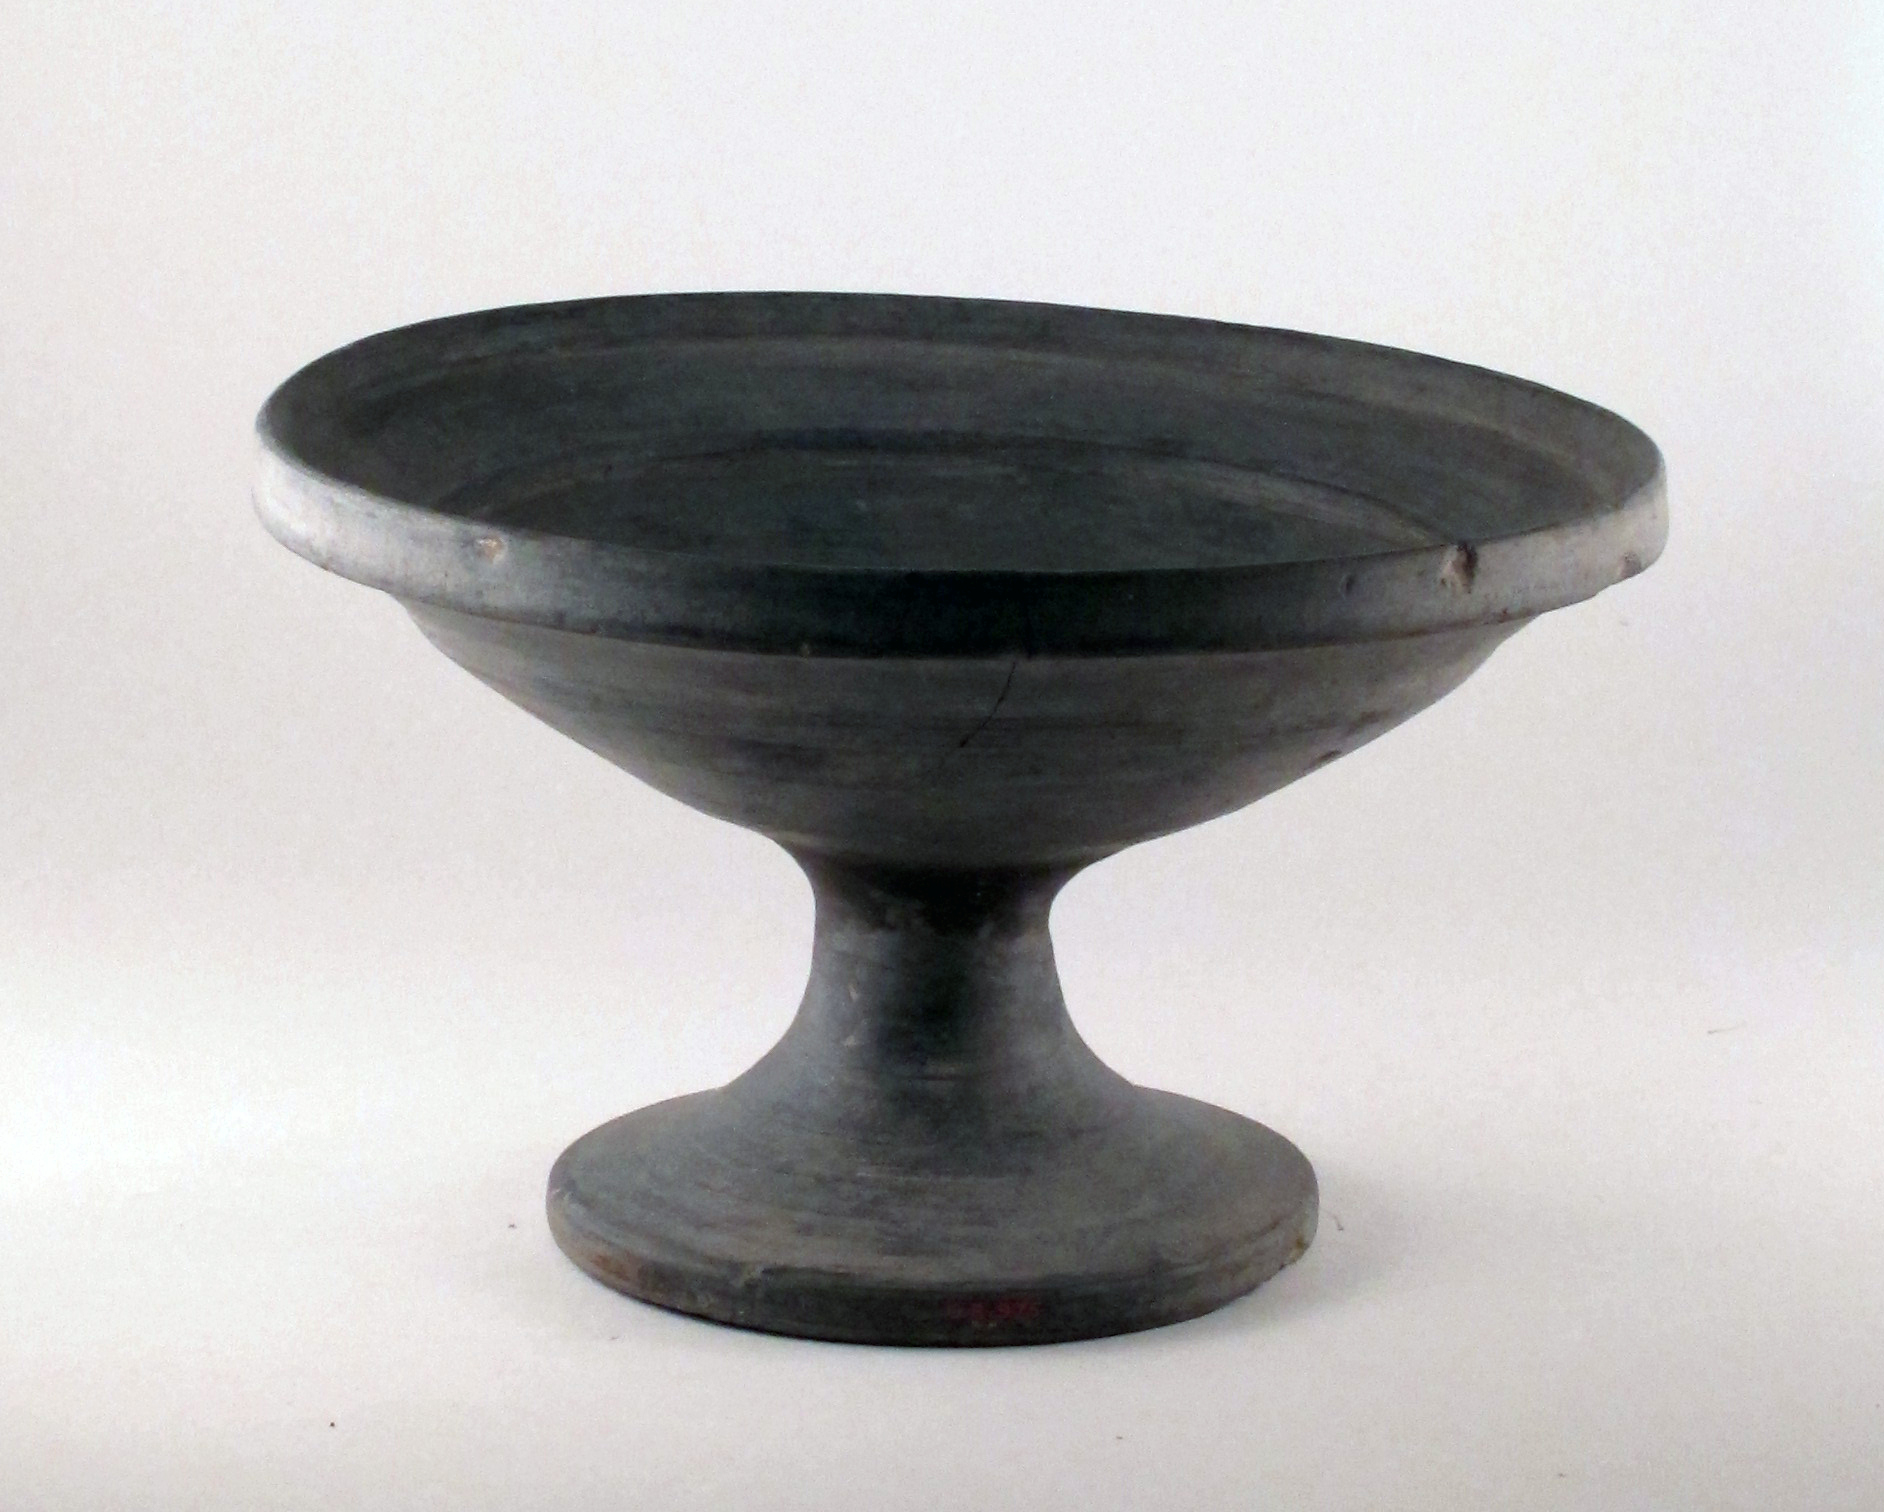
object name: dish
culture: etruscan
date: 550-500 BCE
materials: terracotta